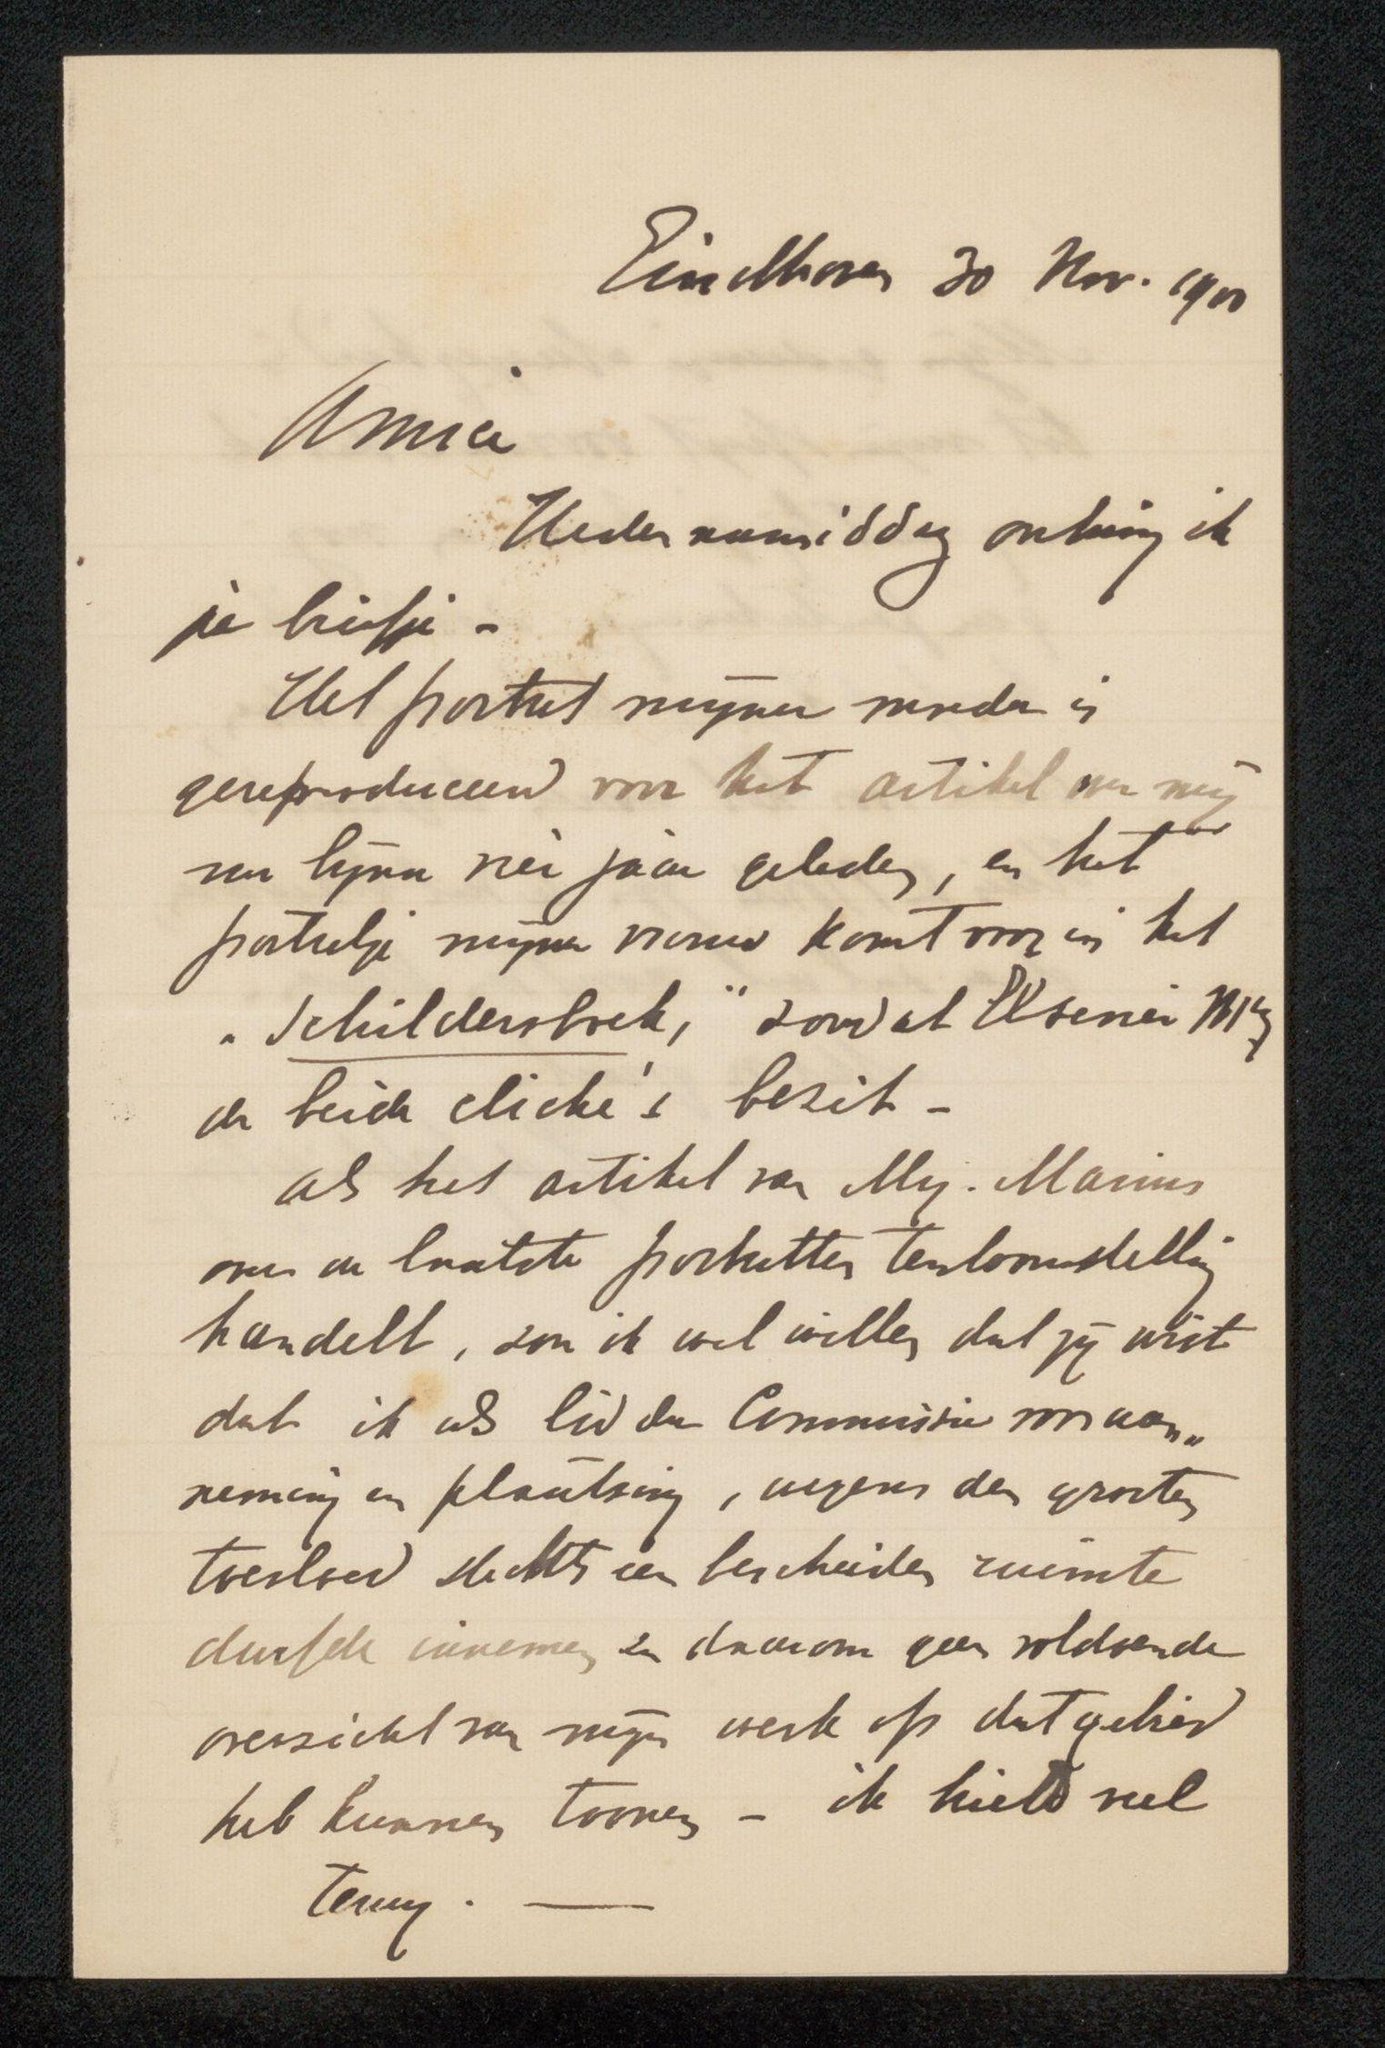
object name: letter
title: Brief aan Philip Zilcken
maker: pieter de josselin de jong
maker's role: draughtsman, painter, print maker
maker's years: 1861-1906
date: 1900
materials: ink, paper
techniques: writing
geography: eindhoven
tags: the hague, philip zilcken, drawing, painting (including book-illumination, miniature-painting), exhibition ~ art, historical persons (portraits and scenes from the life)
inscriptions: collector's mark: ‘RPK’